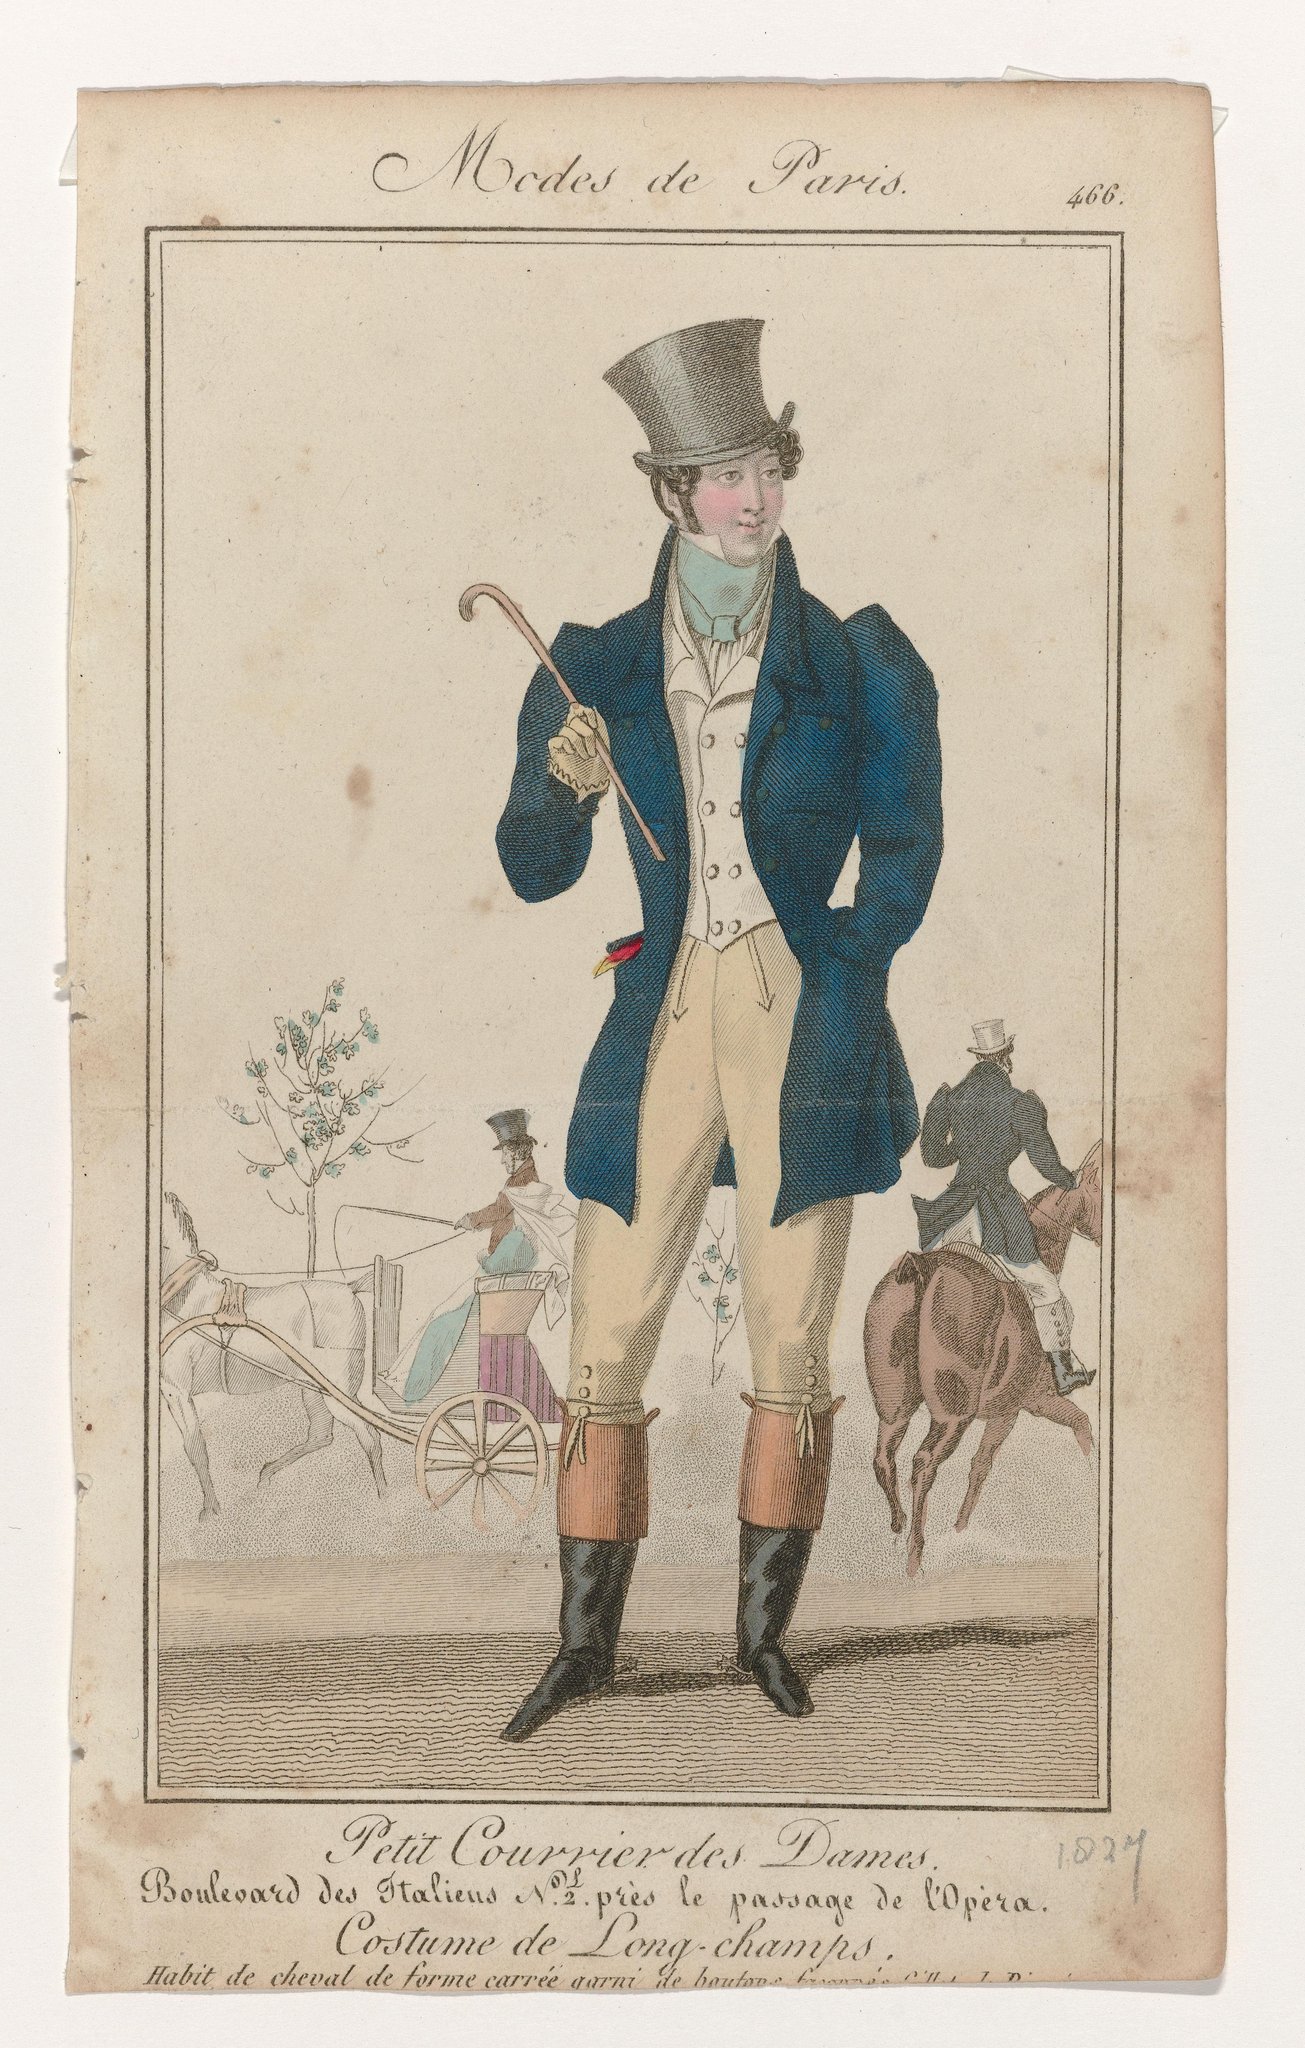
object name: fashion print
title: Petit Courrier des Dames, 1827, No. 466 : Habit de cheval (...)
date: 1827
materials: paper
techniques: engraving, hand coloring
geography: paris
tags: clothing for the upper part of the body (vest) (+ men's clothes), riding a horse, ass, or mule; rider, horseman, neck-gear ~ clothing (+ men's clothes), coat (+ men's clothes), fashion plates, trousers, breeches, etc. (breeches) (+ men's clothes), two-wheeled vehicle drawn by one animal, boots (+ men's clothes), walking-stick, staff, cane (+ men's clothes)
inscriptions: title: ‘Petit Courrier des Dames.’, address: ‘Boulevard des Italiens No.2 près le passage de l'Opera.’, title: ‘Modes de Paris.’, caption: ‘Costume de Long Champs. / Habit de cheval de forme carrée garni de boutons...(ontbreekt)...’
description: 'Costume de Longchamps'. Rijkostuum. 'Habit de cheval' met vierkante panden en knopen. Vest van piqué met revers en dubbele rij knopen. Kniebroek van suéde. Tweekleurige laarzen of 'Bottes Anglaises en castor gris de Gérard'. Geknoopte halsdoek. Accessoires: hoge hoed met een smalle opstaande rand, handschoen, wandelstok. Op de achtergrond: ruiter te paard en een paar zittend in een rijtuig. Prent uit het modetijdschrift Petit Courrier des Dames (1821-1868).